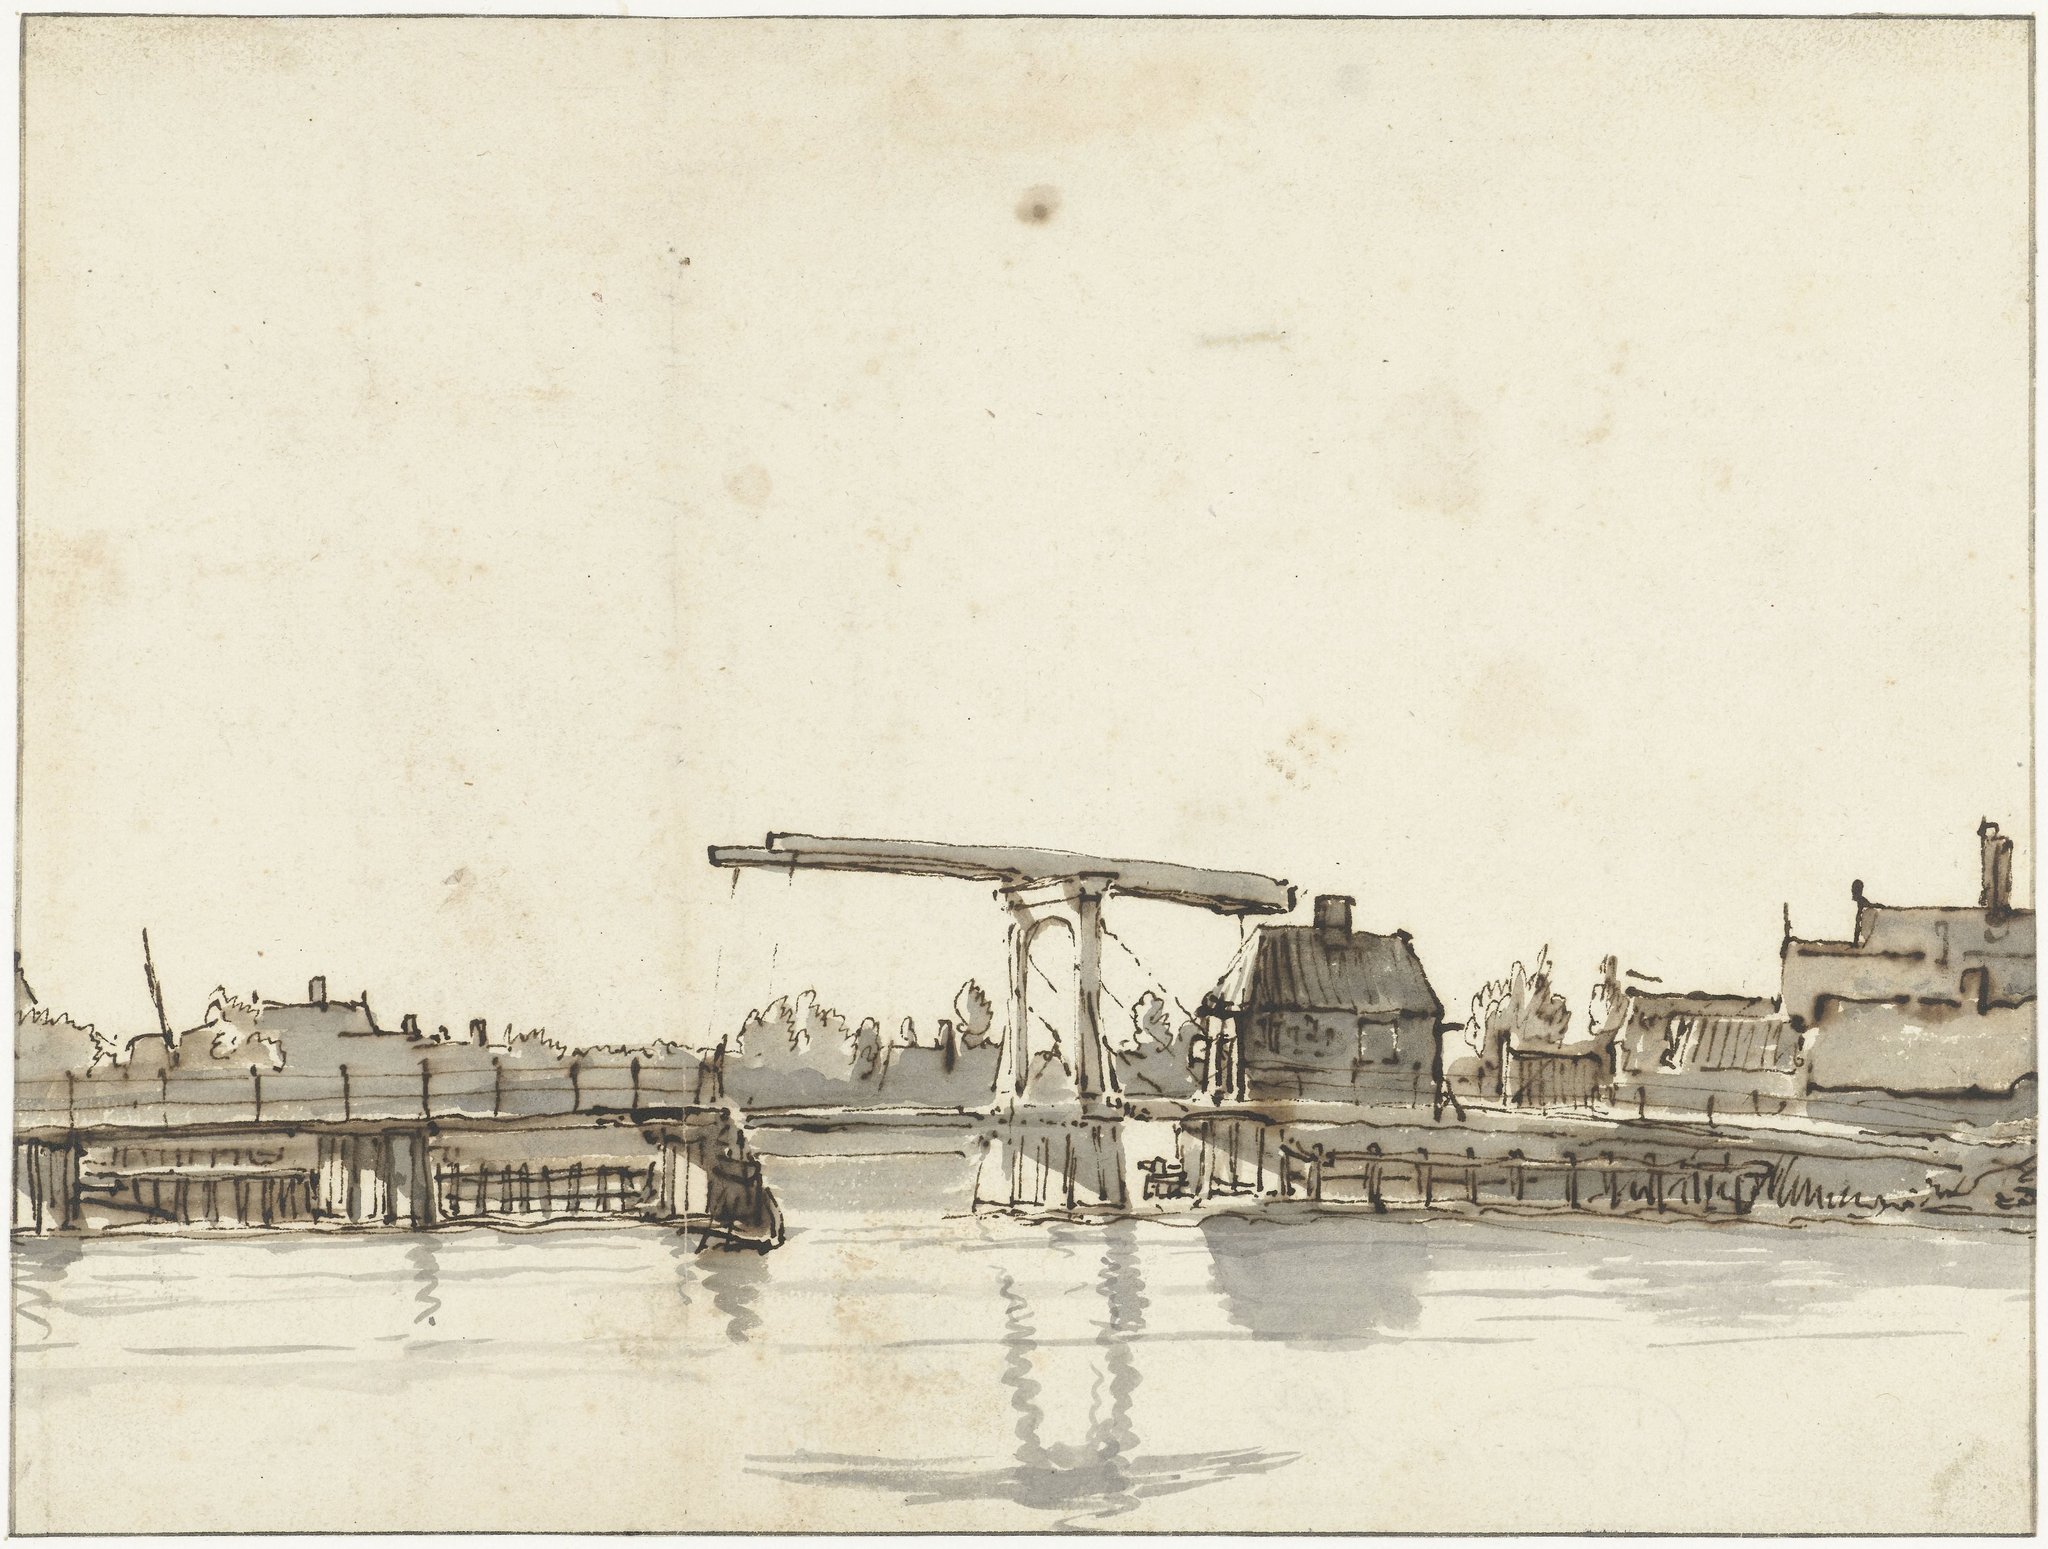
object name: drawing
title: Ophaalbrug te Ouderkerk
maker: jan hulswit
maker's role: draughtsman, painter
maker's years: 1766-1822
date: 1776-1822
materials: ink, paper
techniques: brush, pen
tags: bridge in city across river, canal, etc.